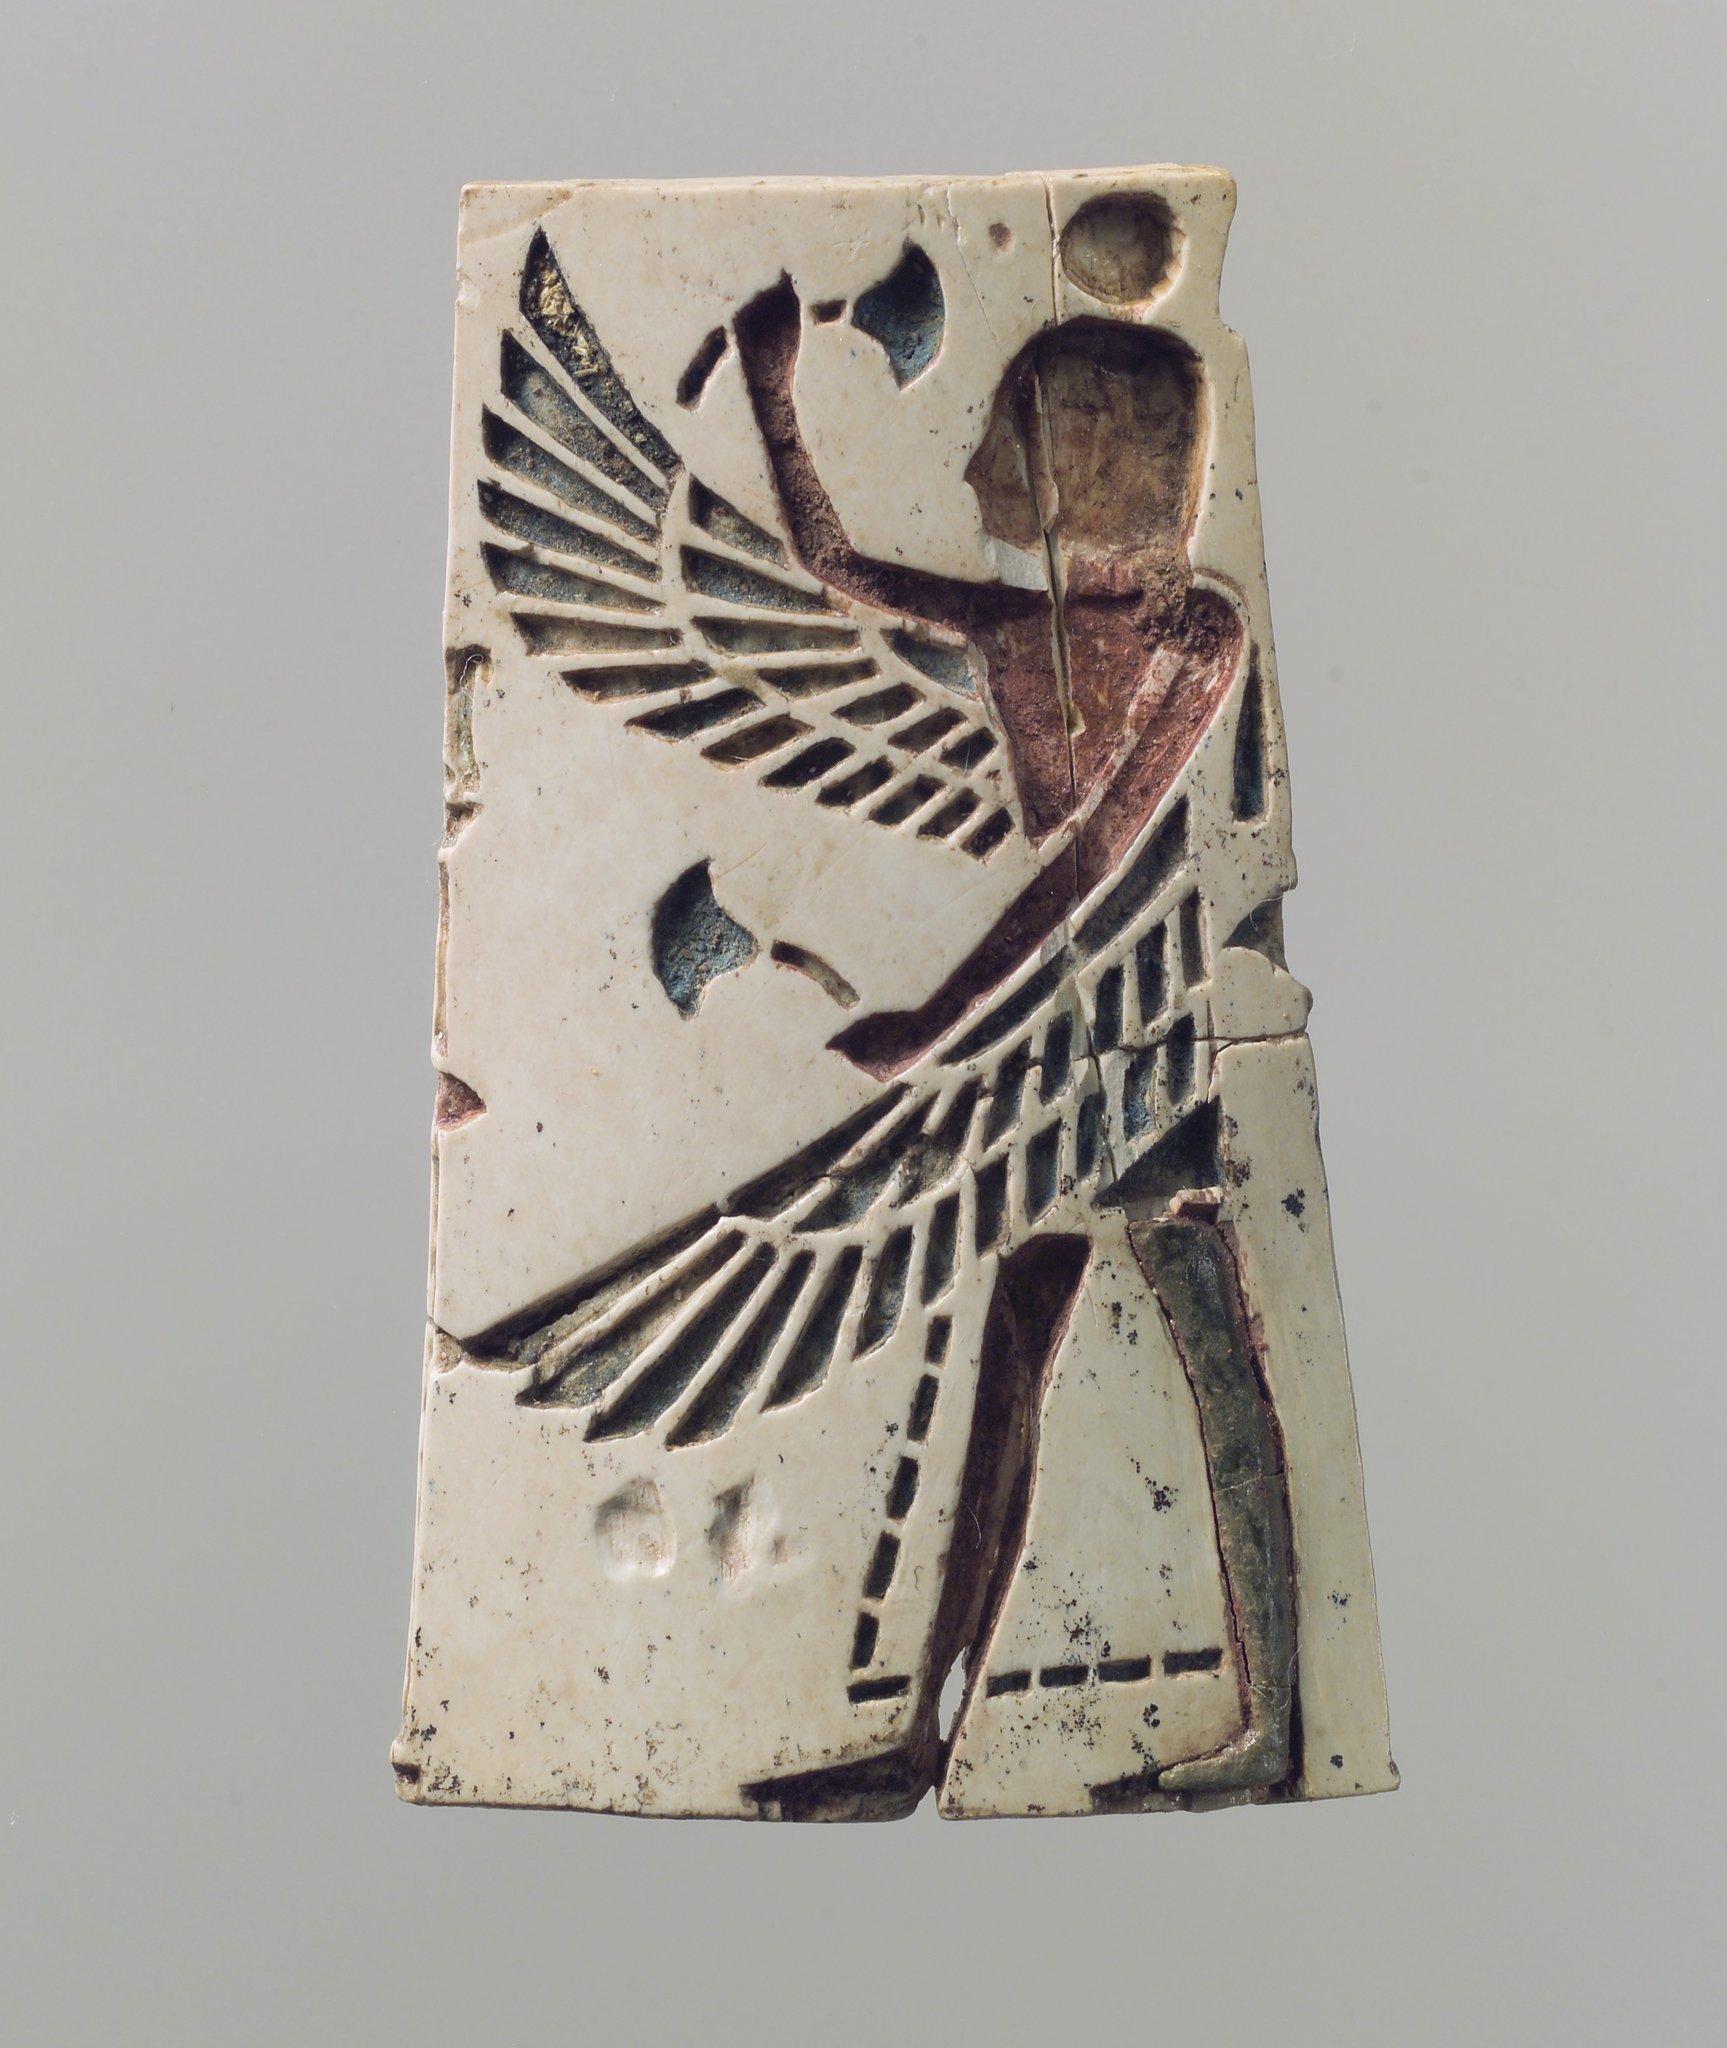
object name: vessel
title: Champlevé furniture or cosmetic box plaque with a winged youth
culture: assyrian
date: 800-601 BCE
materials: ivory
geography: mesopotamia